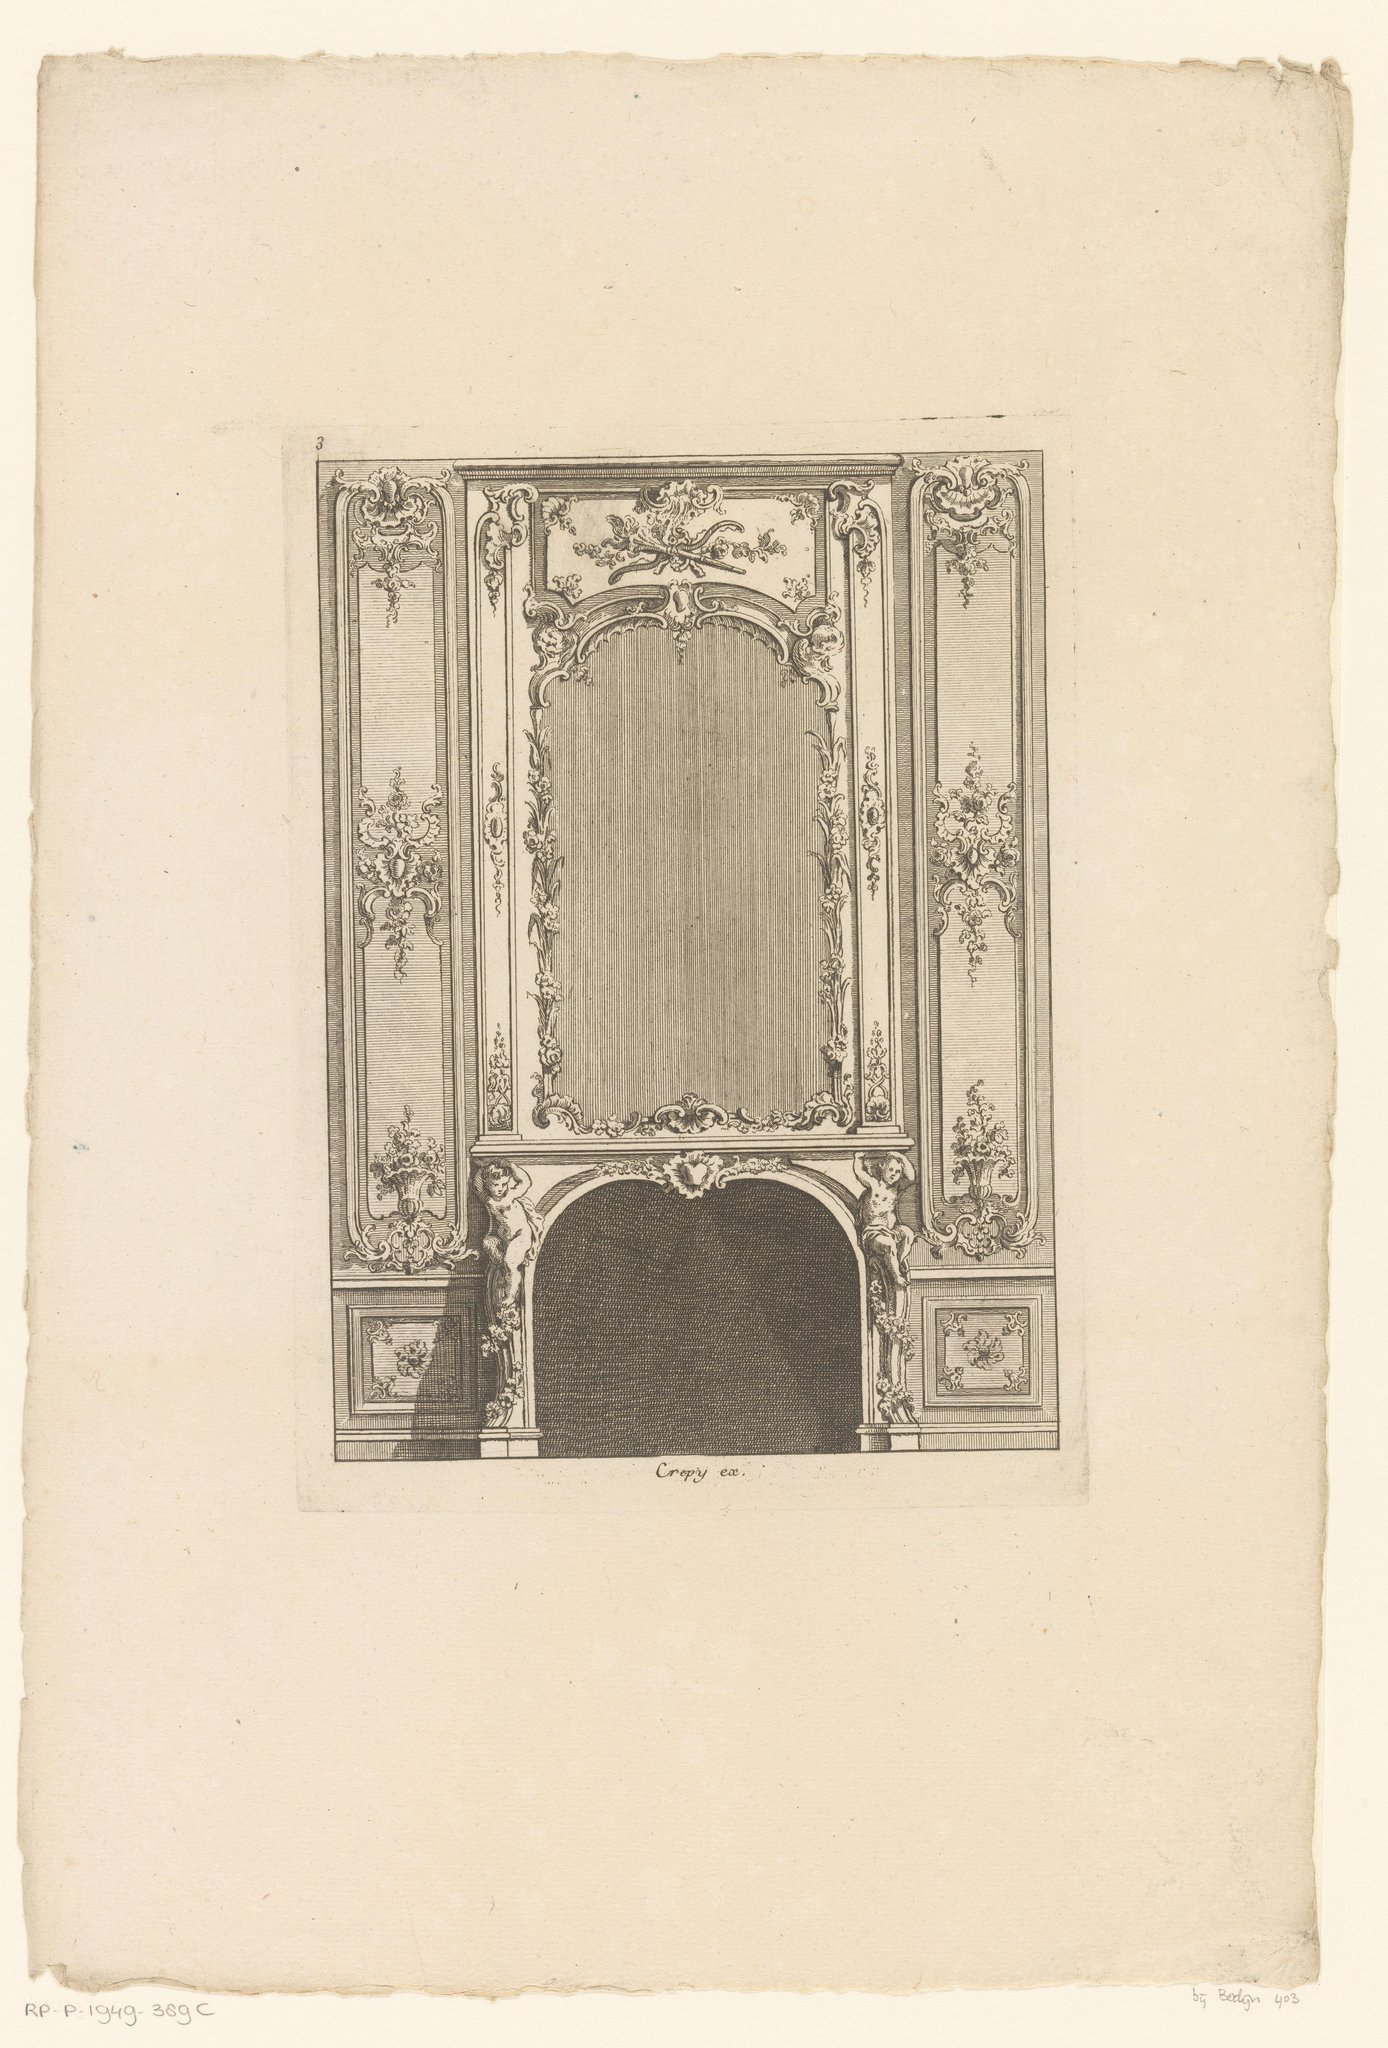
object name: ornament print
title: Schouw met putti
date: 1749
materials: paper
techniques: engraving, etching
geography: paris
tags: open hearth, fire-place, cupids: 'amores', 'amoretti', 'putti'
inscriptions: collector's mark: Lugt 2228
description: Onder het adres van uitgever Crepy is nog licht een oud adres zichtbaar. Op prent twee uit de serie (RP-P-1949-389B) vermeld: Chereau au Coq.